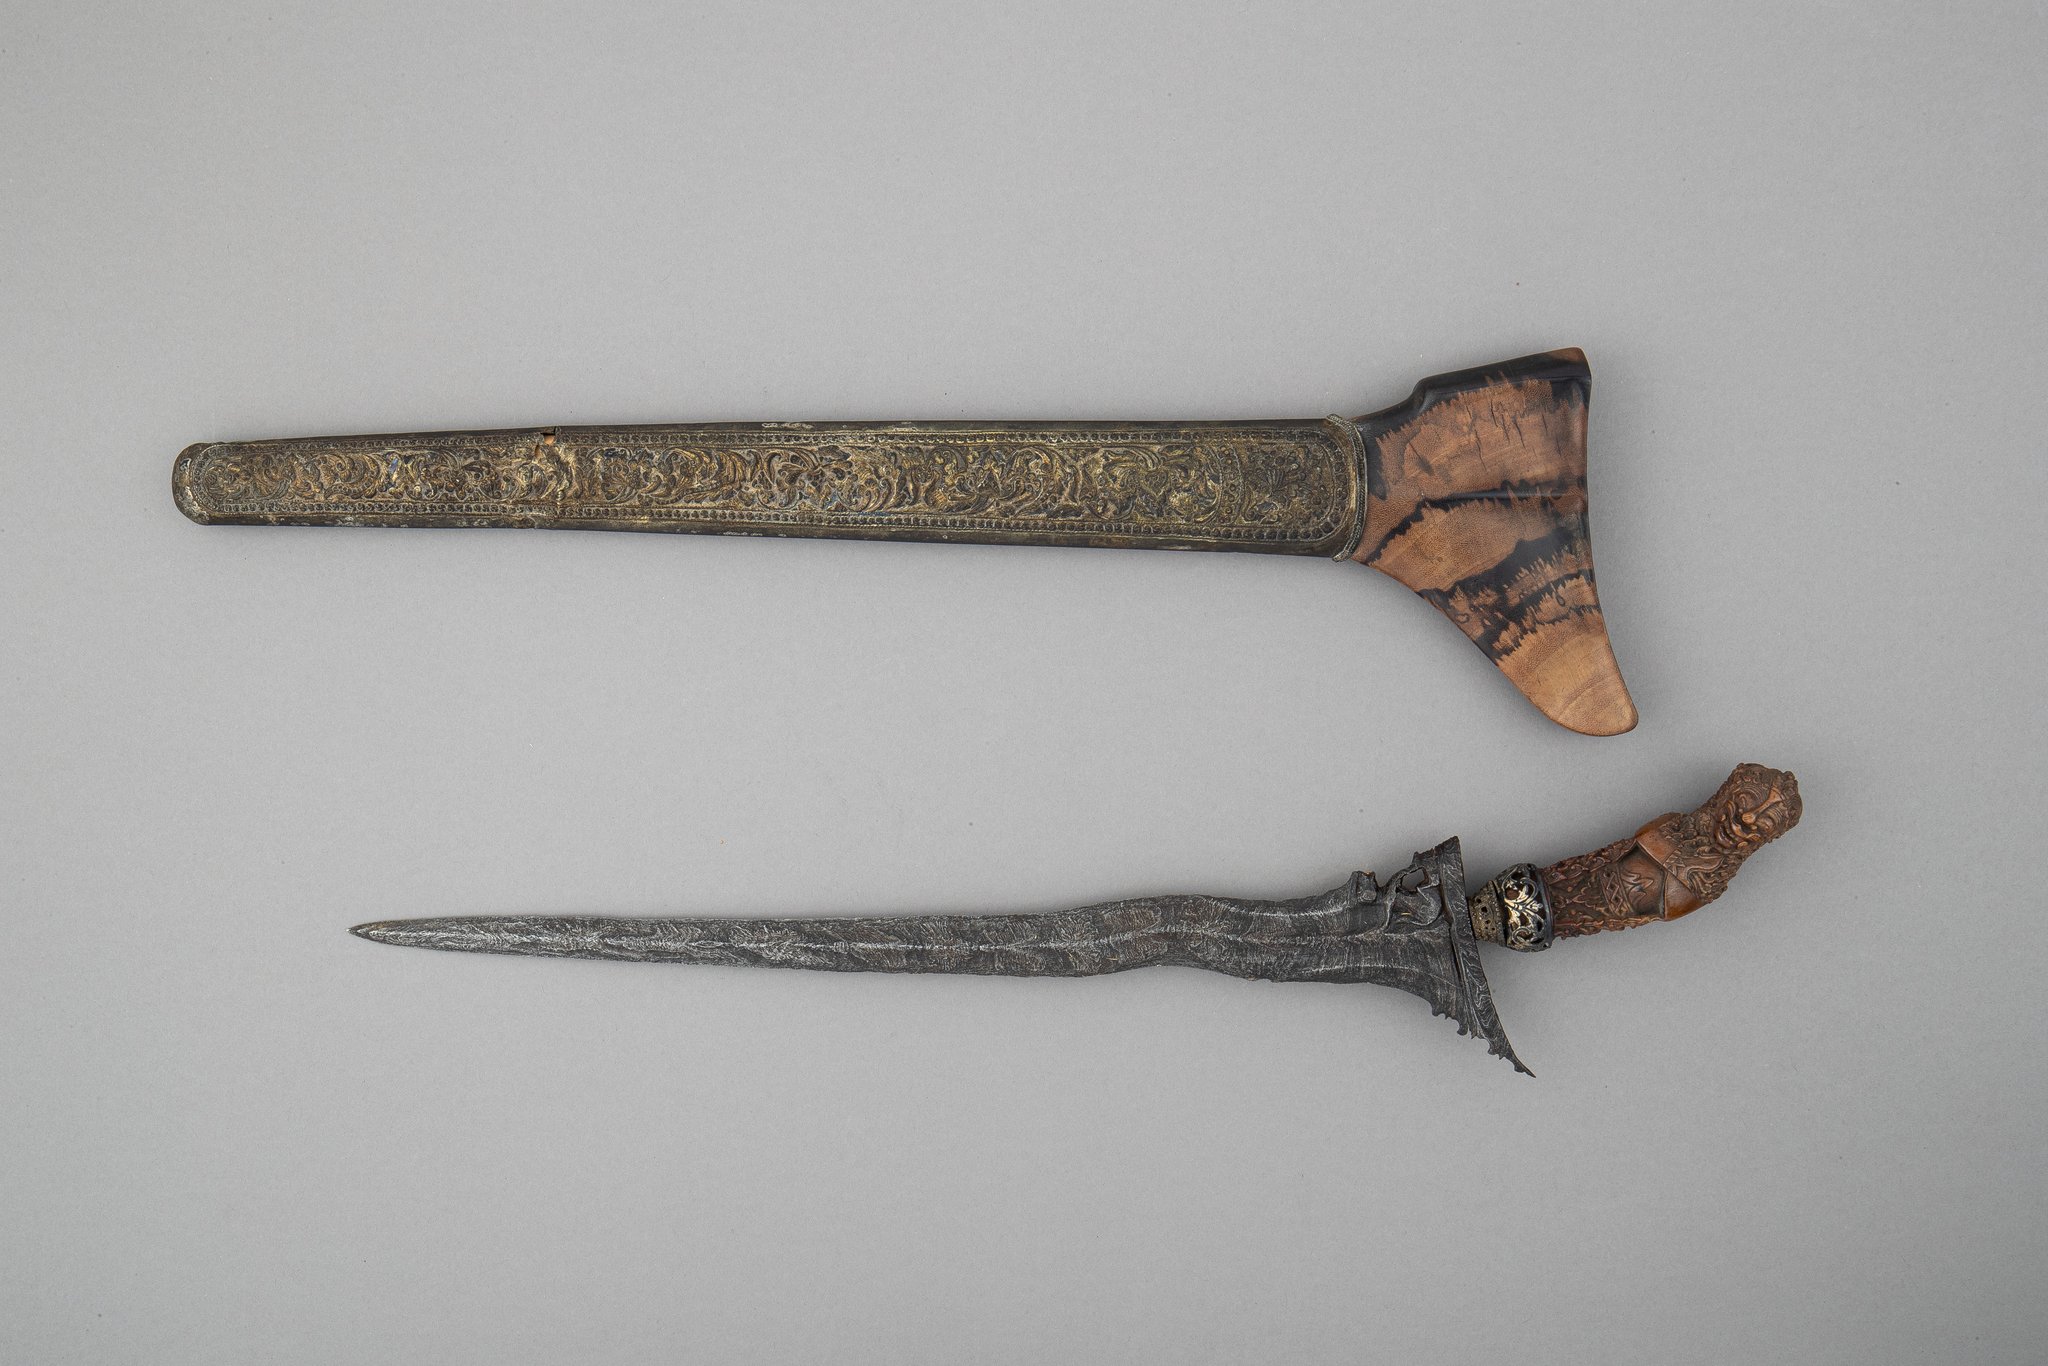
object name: kris with sheath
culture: javanese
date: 1501-1900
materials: silver, steel, wood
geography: indonesia